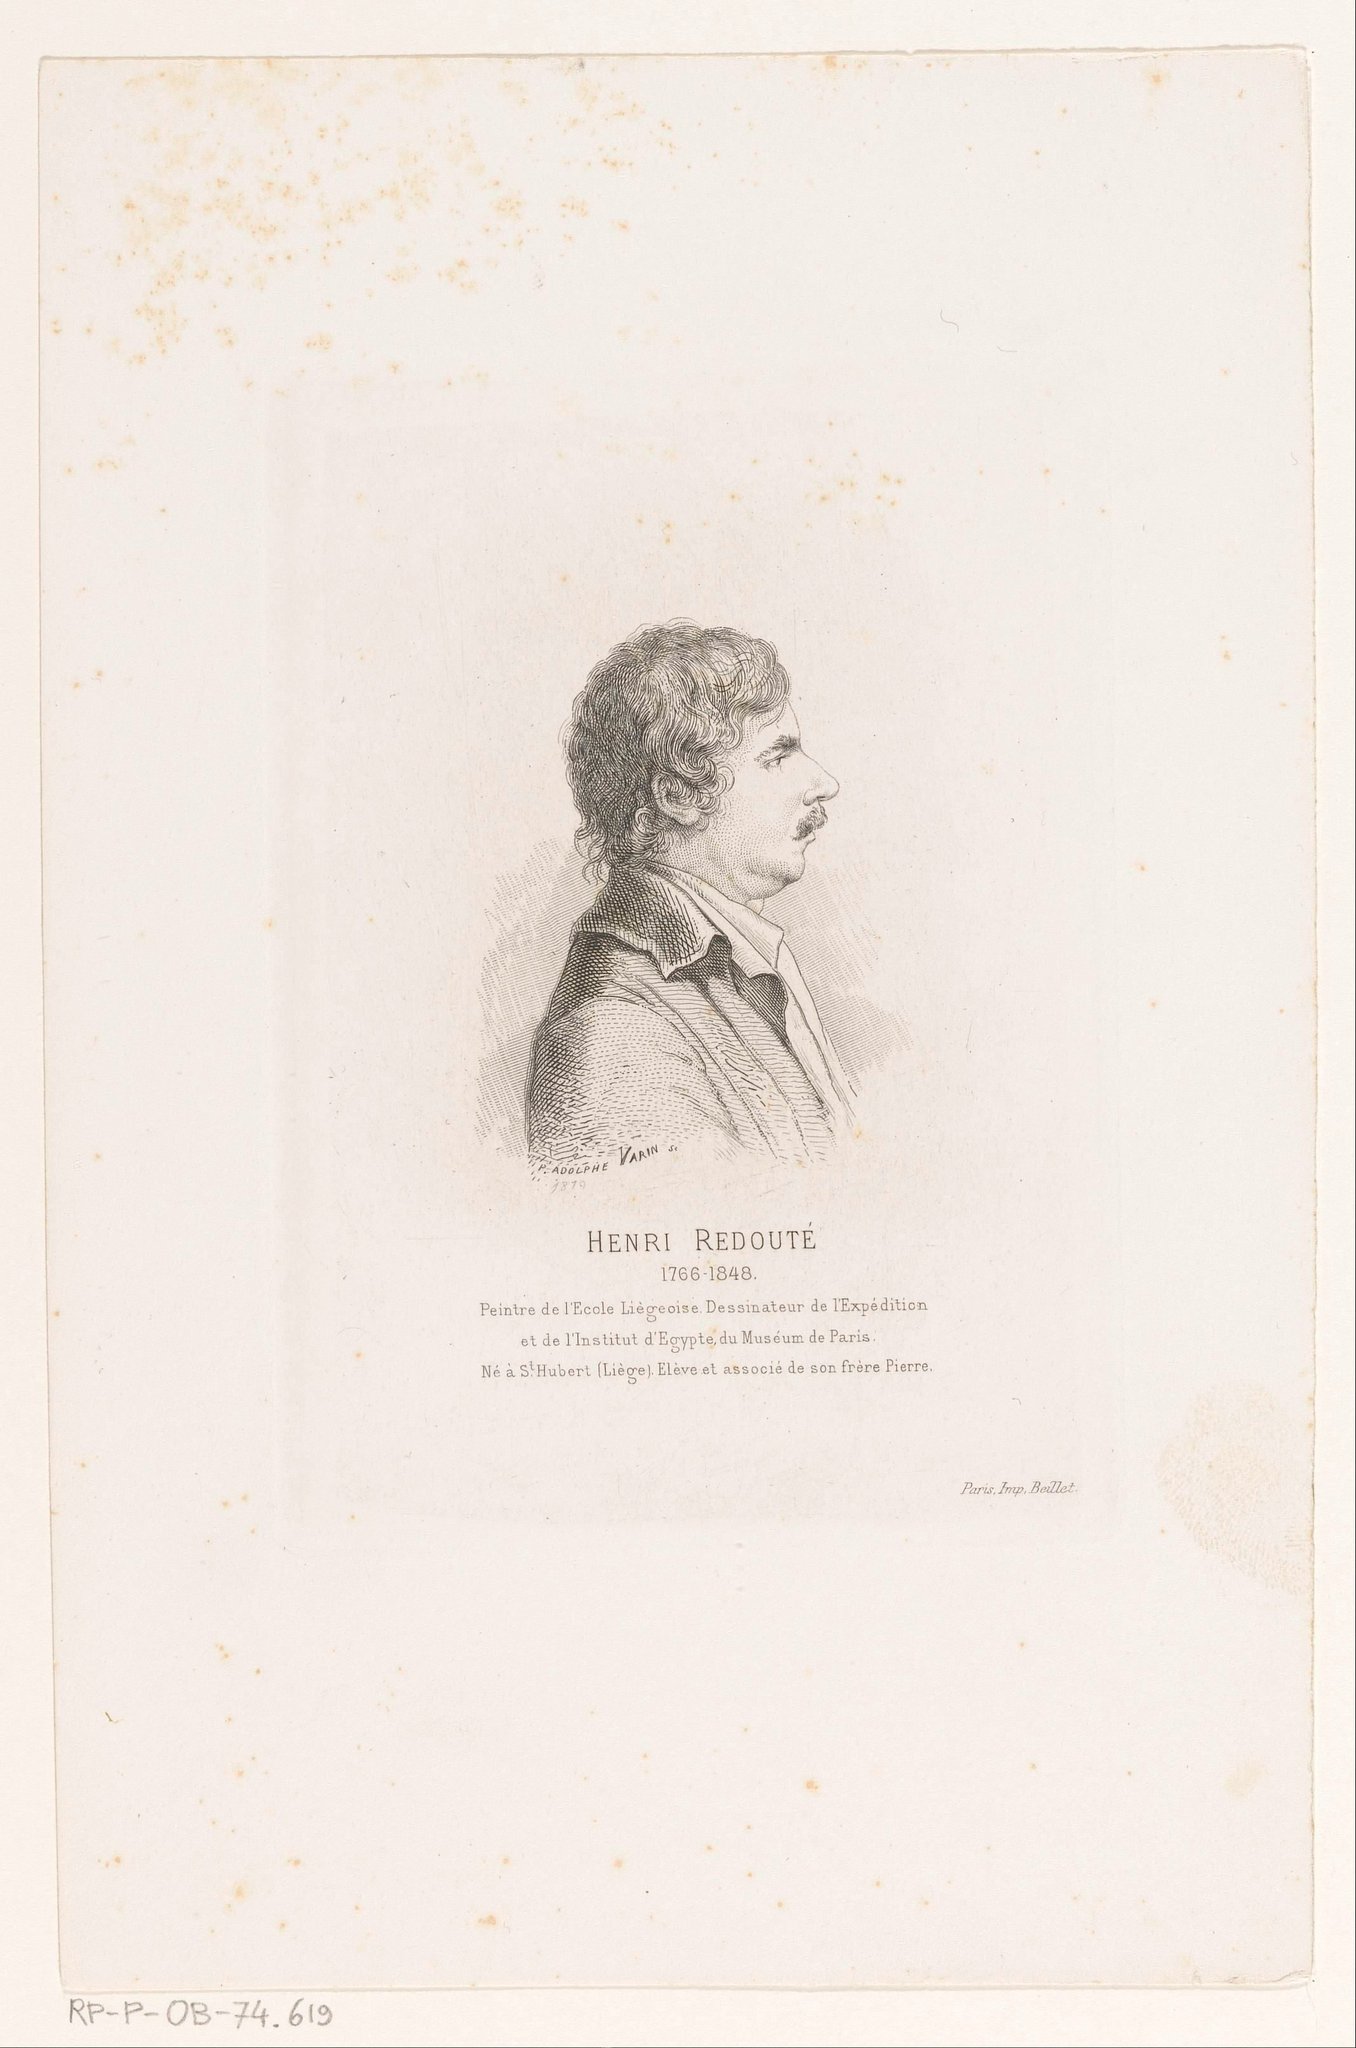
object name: print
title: Portret van Henri-Joseph Redouté, en profil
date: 1879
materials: paper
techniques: etching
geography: paris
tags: paris, painter, print maker, draughtsman, henri-joseph redouté, historical persons, portrait, self-portrait of artist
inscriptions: collector's mark: Lugt 2228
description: Prent uit: École liégeoise. Les Graveurs. Leurs portraits, reproduits au burin, d'après les originaux, par Adolphe Varin, 1366-1850. Avec notes historiques (...). Parijs: Fr. Gobbaerts, ca. 1684.